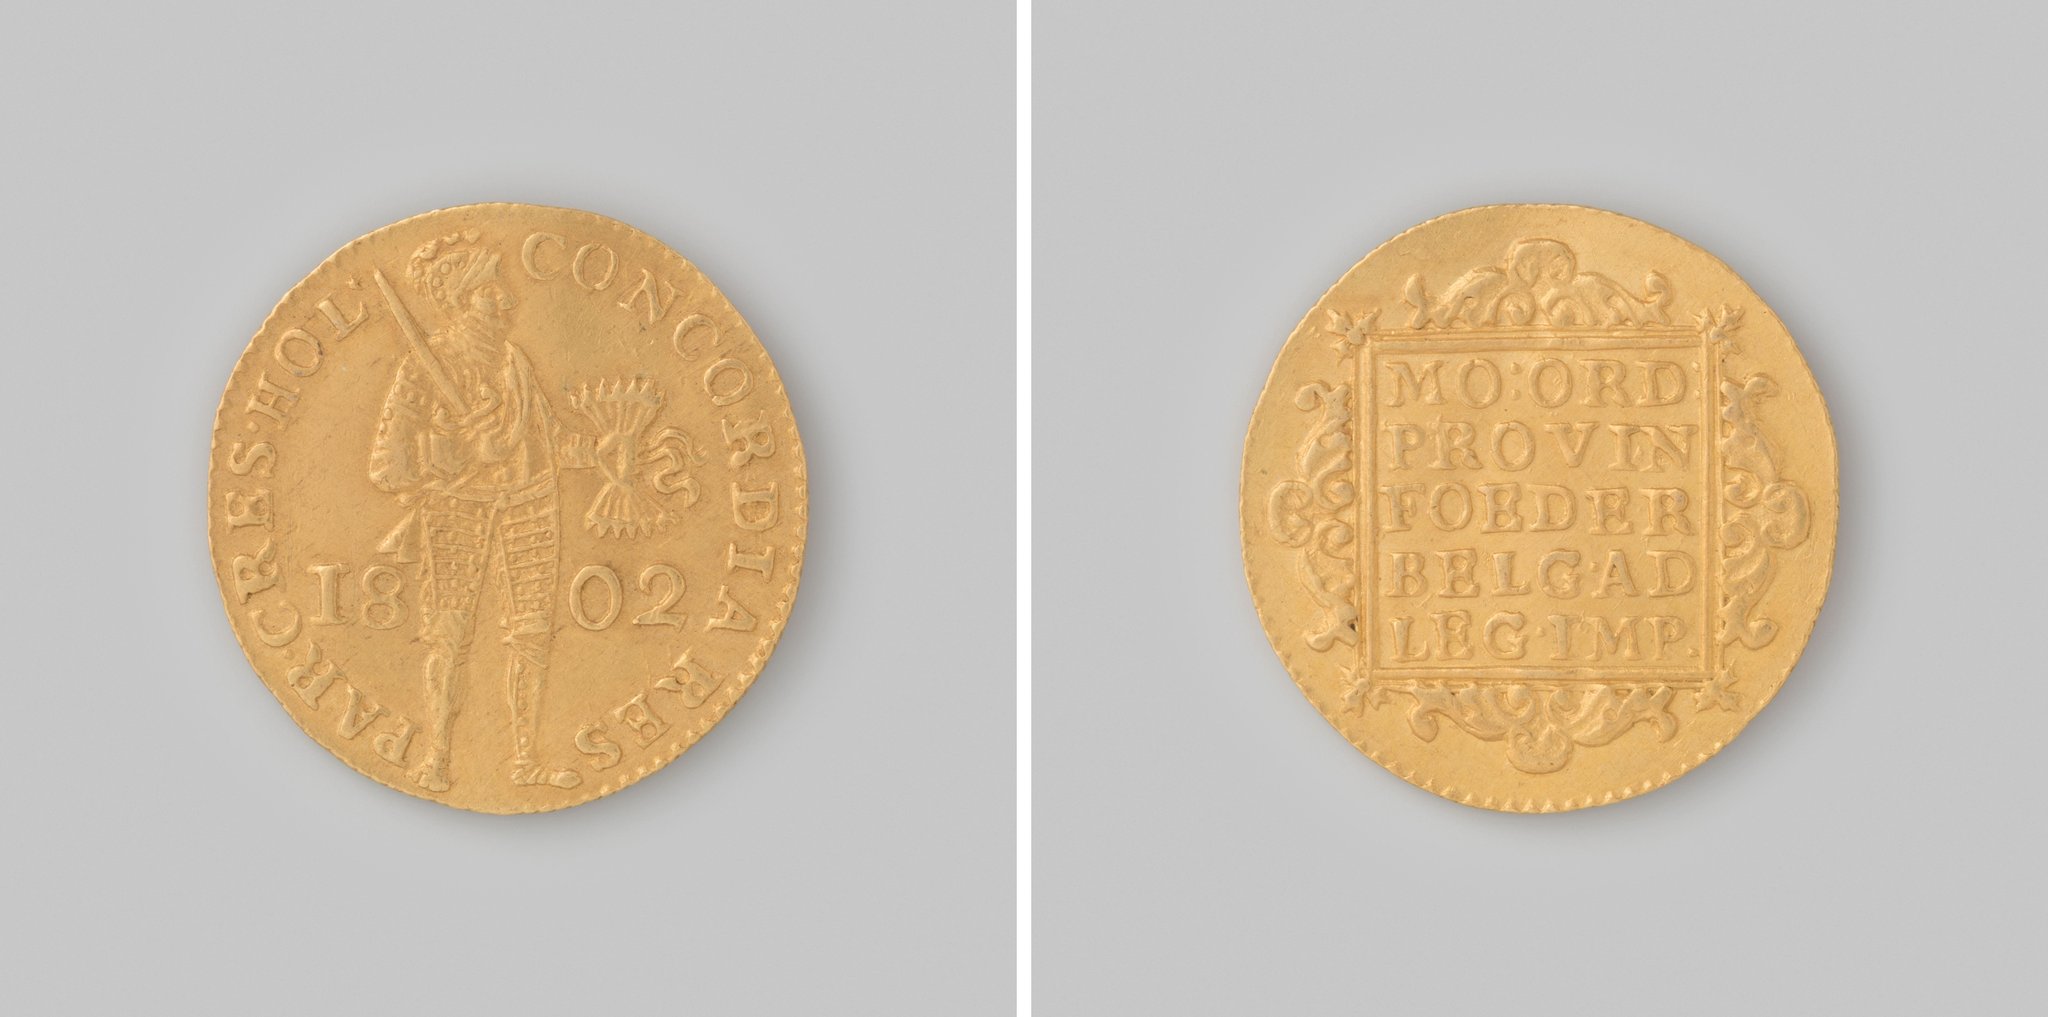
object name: gouden dukaat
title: Dukaat van de Bataafse Republiek op naam van Holland, 1802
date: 1802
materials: gold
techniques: striking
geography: dordrecht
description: Gouden munt. Voorzijde: tussen jaartal staande ridder met zwaard en pijlenbundel. Omschrift eindigend in HOL. Keerzijde: in een versierd vierkant vijf-regelig opschrift. Kabelrand.